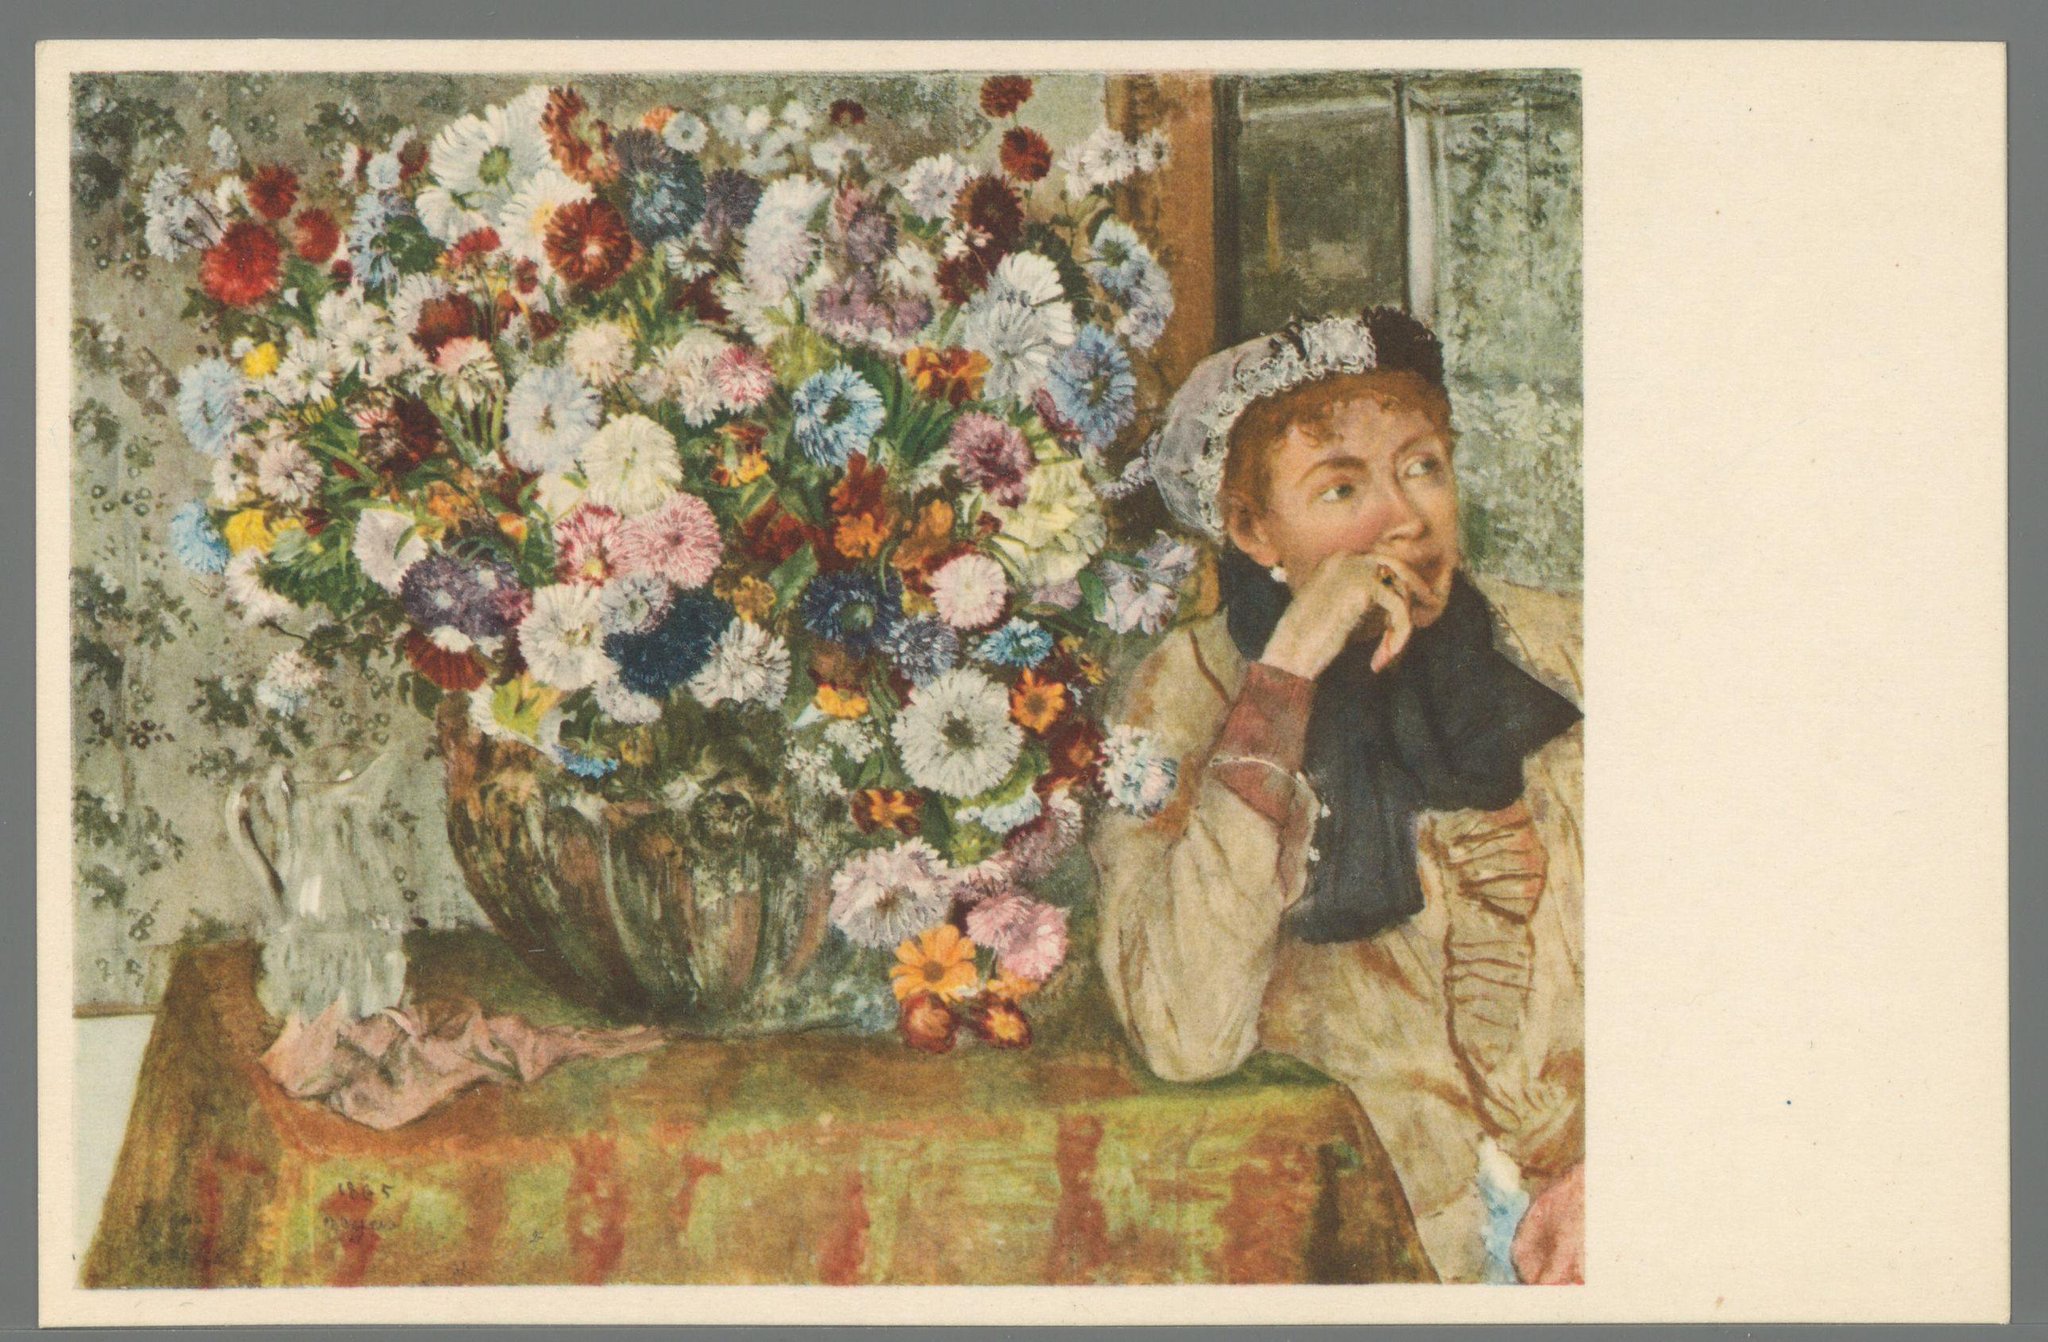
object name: reproduction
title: Woman with Chrysanthemums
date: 1929-1940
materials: cardboard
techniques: photograph, lithograph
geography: vienna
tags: flowers: chrysanthemum, adult woman (+ sitting)